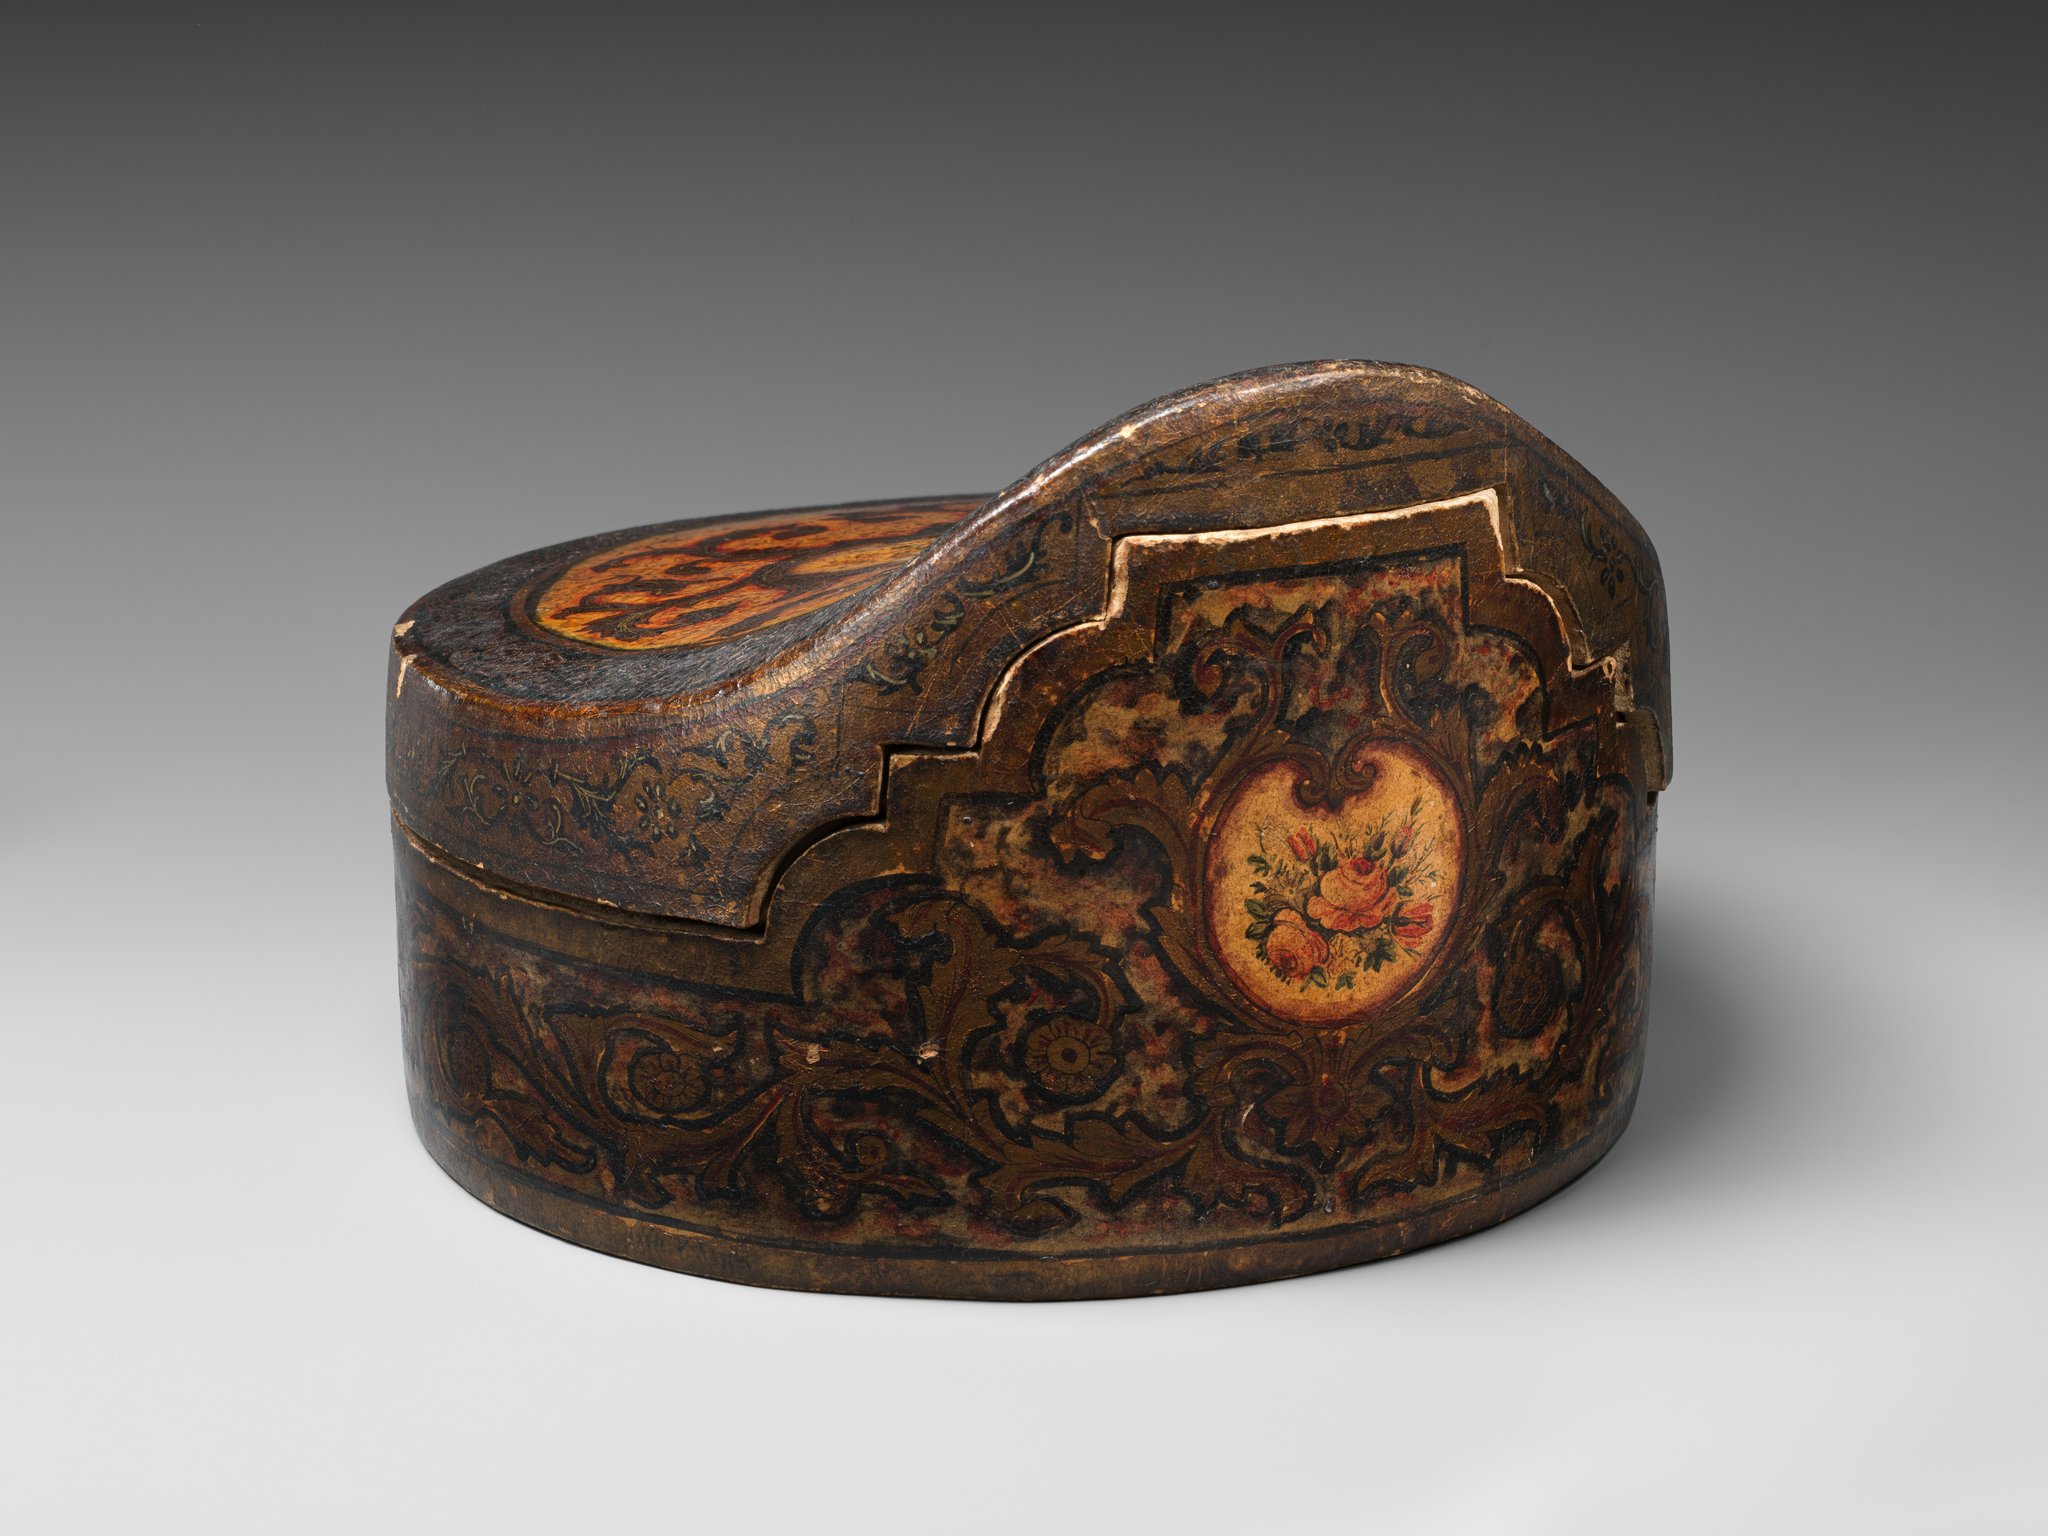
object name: box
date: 1701-1800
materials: paper, varnish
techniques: painting